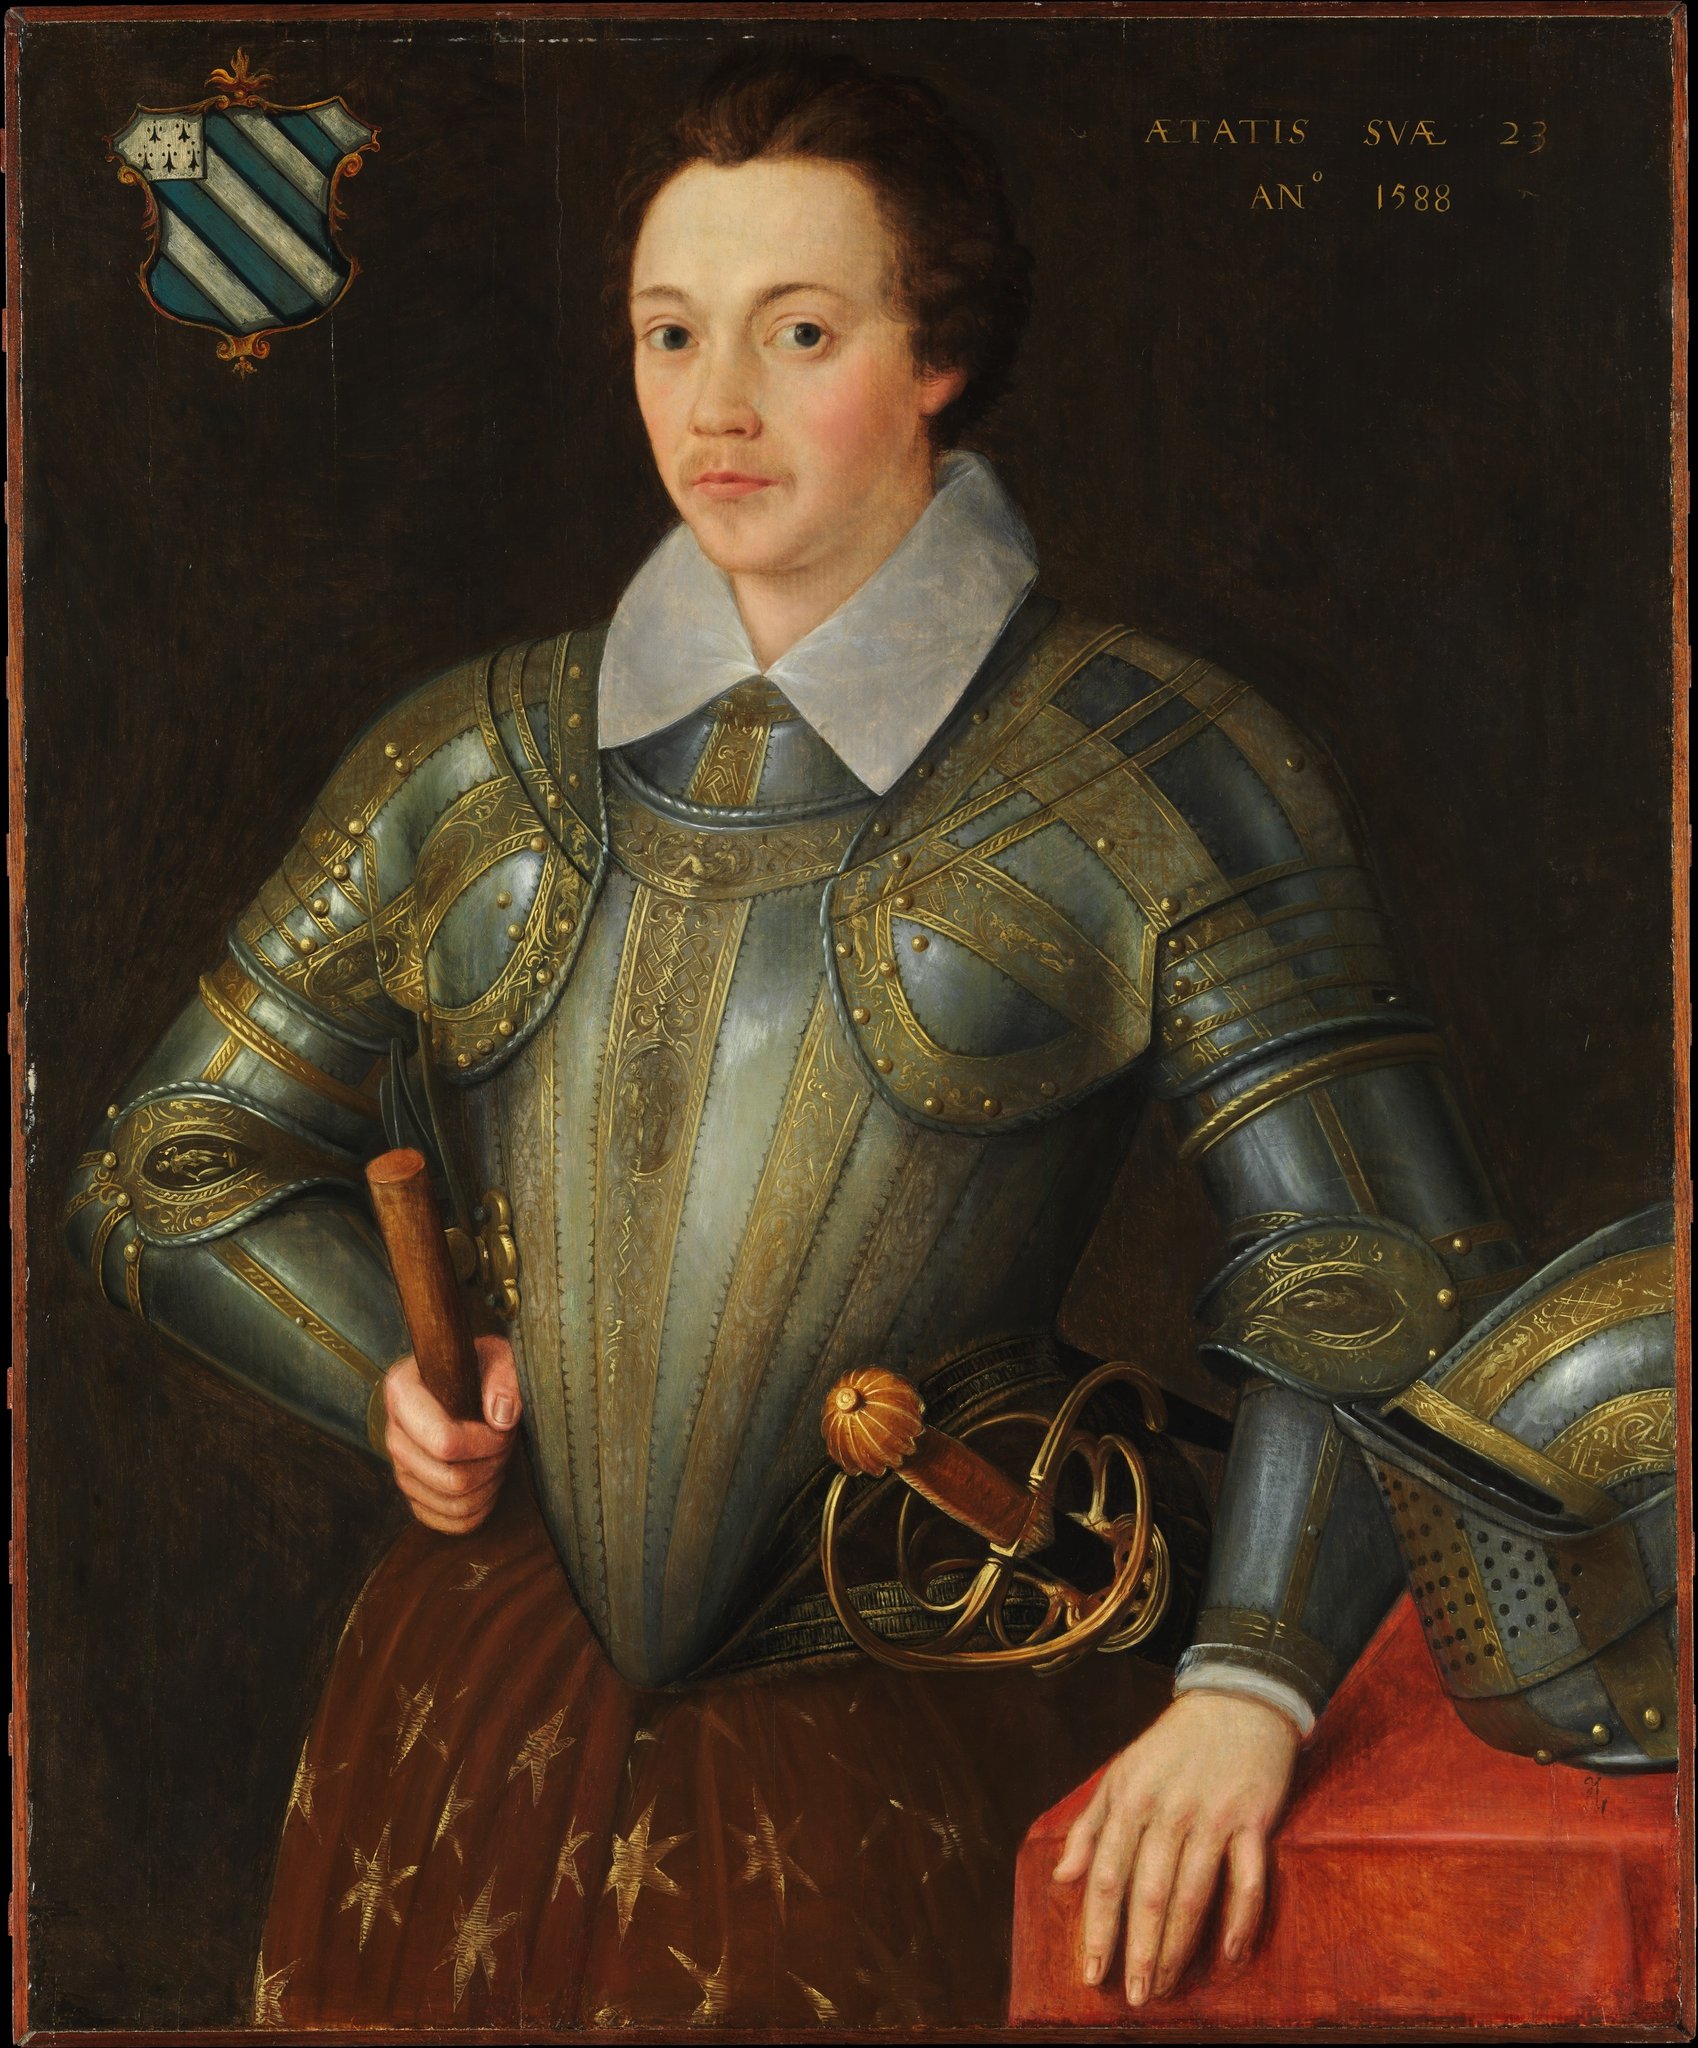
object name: painting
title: Sir John Shurley of Isfield (1565–1632)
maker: british painter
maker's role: artist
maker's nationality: british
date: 1588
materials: oil, wood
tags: armor,men,portraits